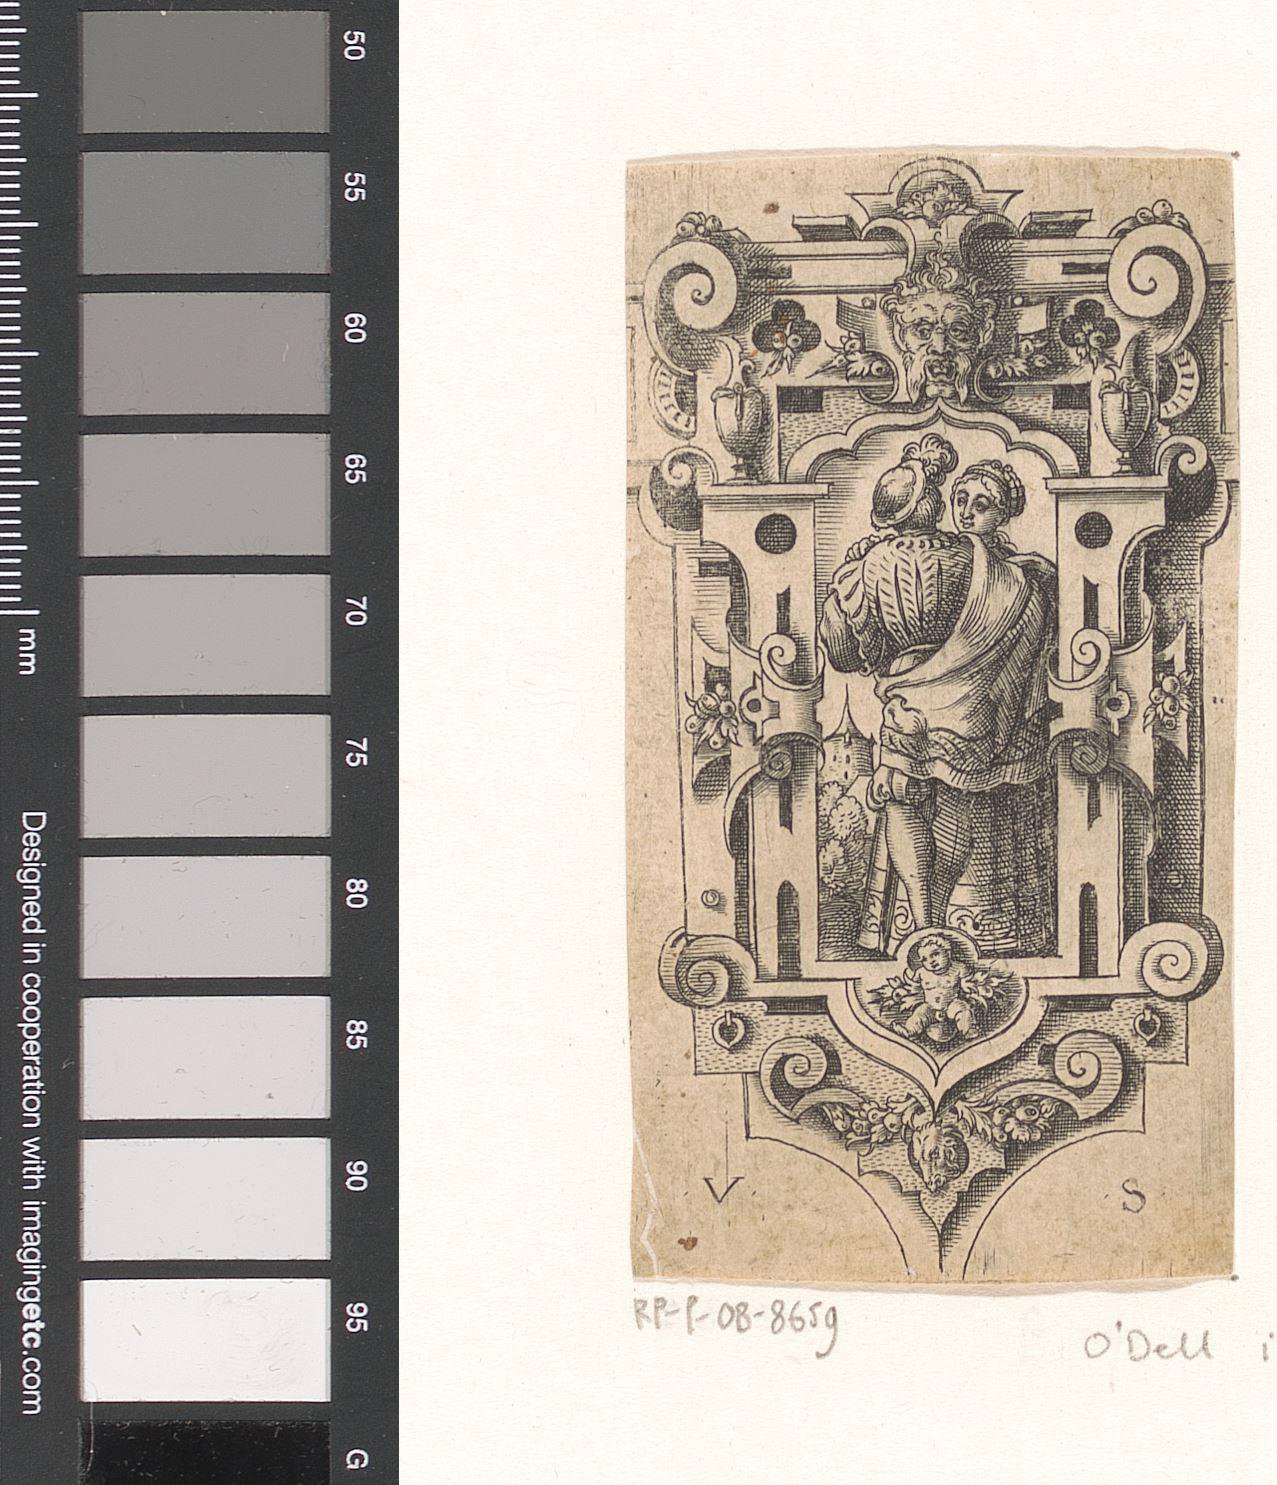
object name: ornament print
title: Gedeelte van een schede met staand paar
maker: virgilius solis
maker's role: draughtsman, print maker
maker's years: 1514-1562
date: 1524-1562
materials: paper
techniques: engraving, etching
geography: nuremberg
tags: scrollwork, strapwork ~ ornament, scabbard, sheath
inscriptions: number: ‘127’, collector's mark: Lugt 2228